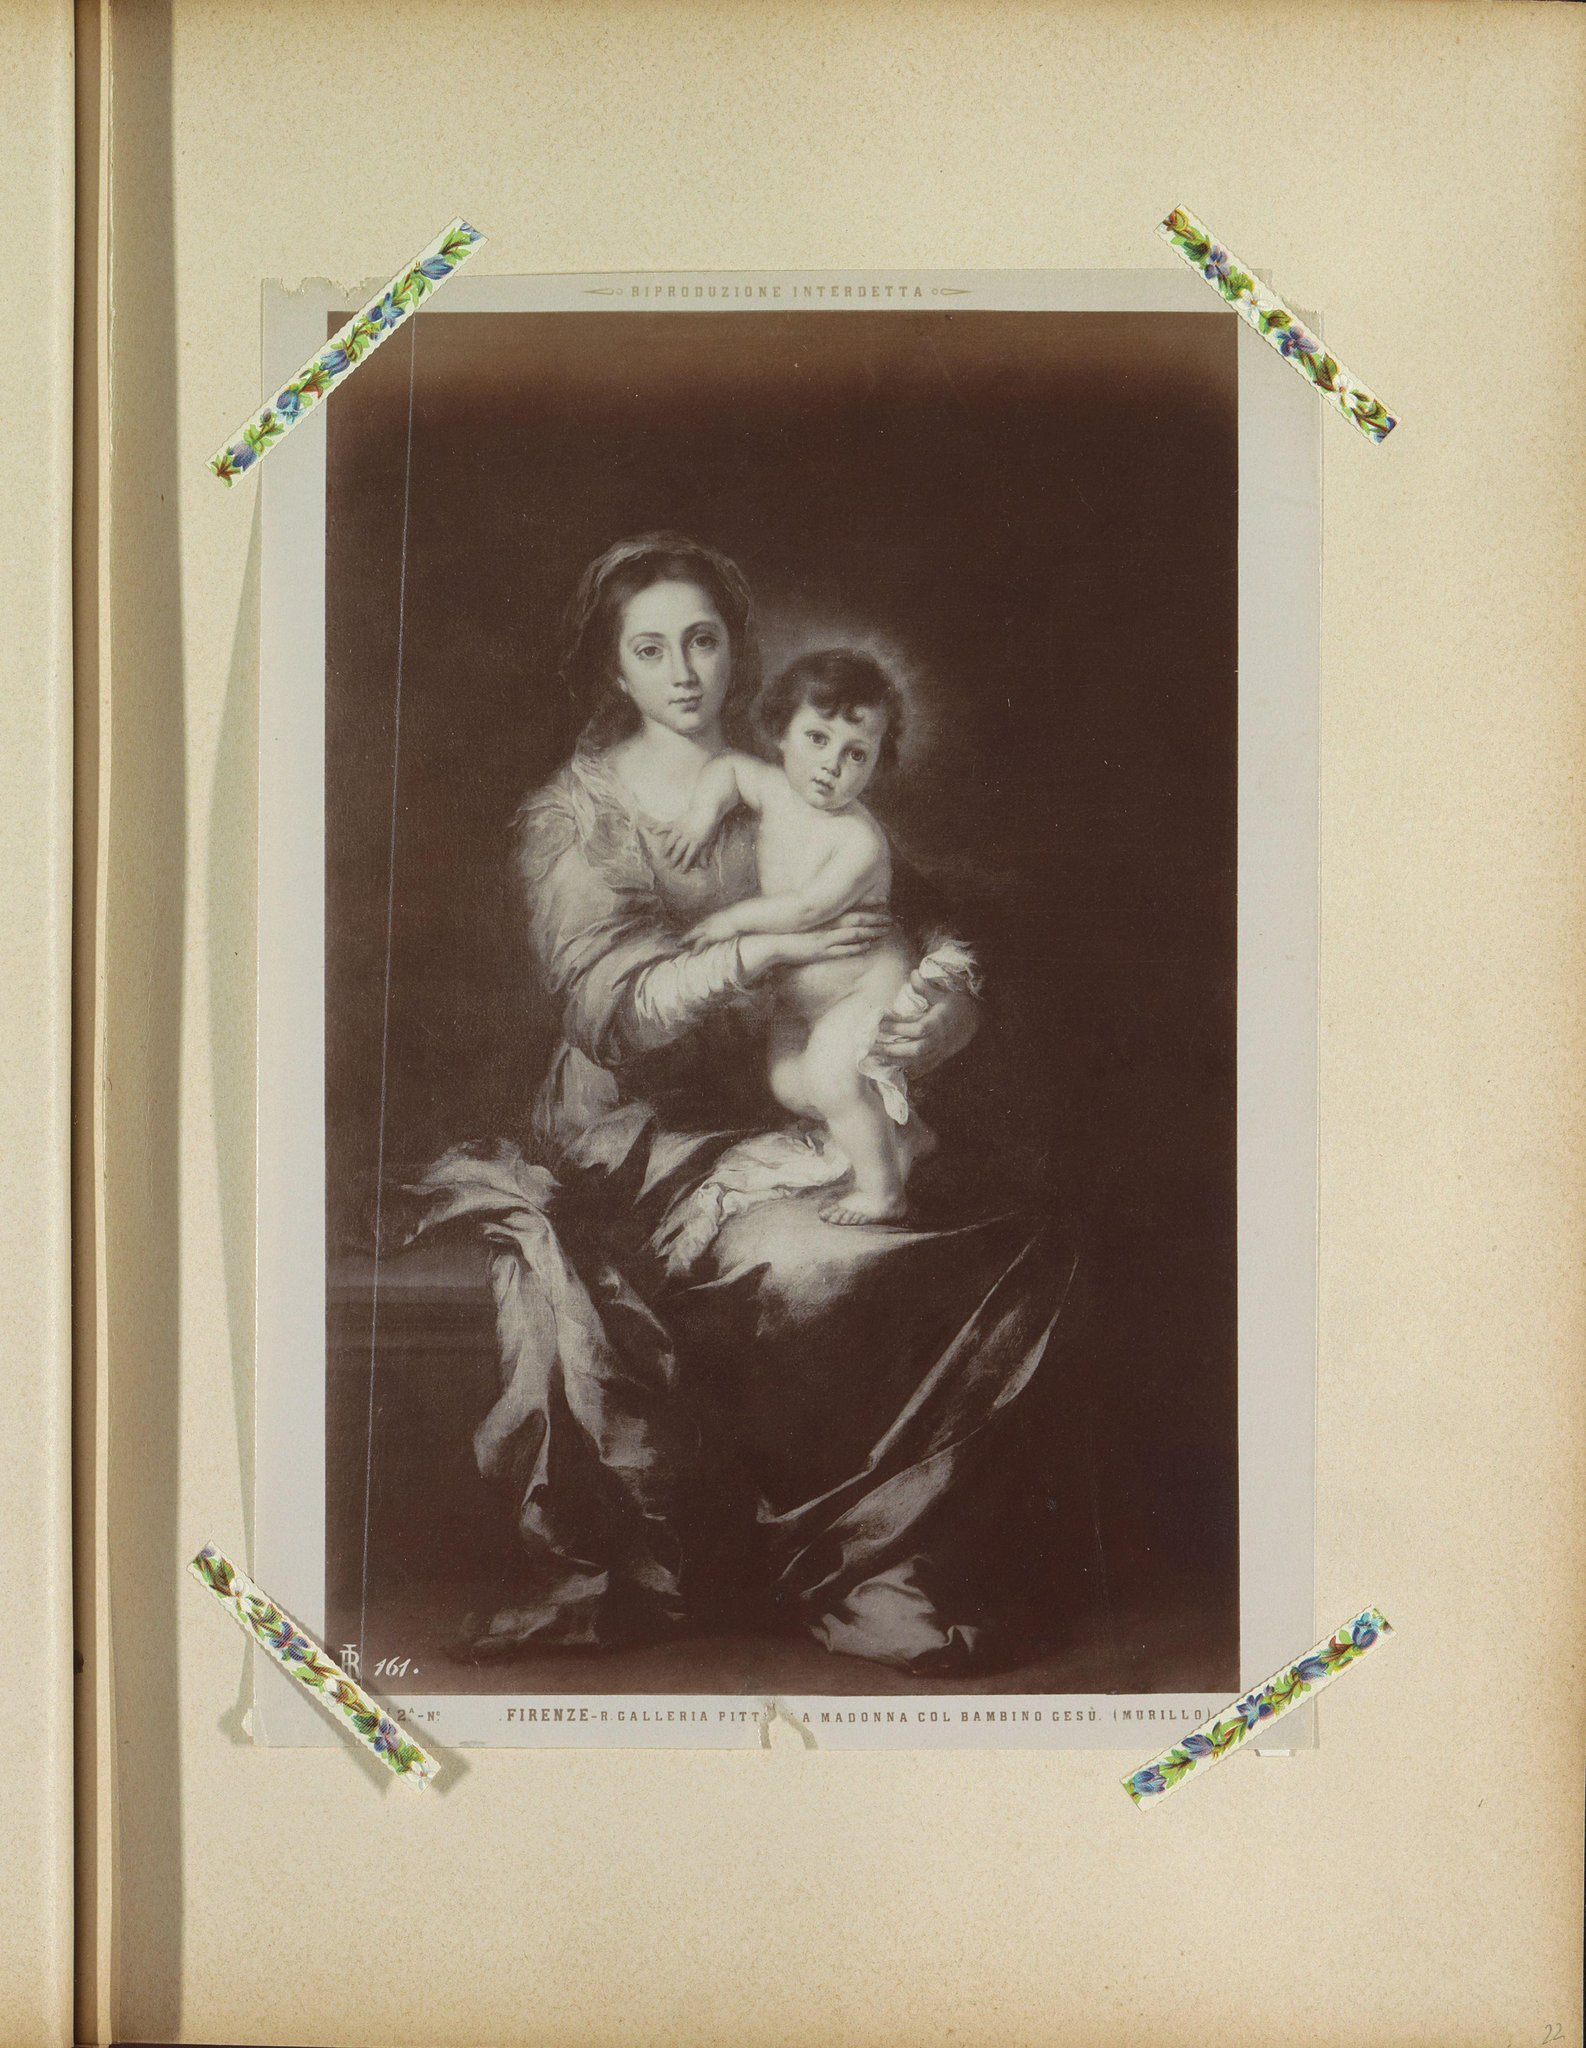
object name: reproduction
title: Fotoreproductie van een schilderij door Bartolomé Esteban Murillo, voorstellend Maria met Kind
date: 1860-1900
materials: photographic support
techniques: albumen print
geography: florence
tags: madonna: i.e. mary with the christ-child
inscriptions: inscription: ‘IR’, number: ‘161’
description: Onderdeel van Fotoalbum met opnames van bezienswaardigheden in Italiaanse steden en van kunstwerken.